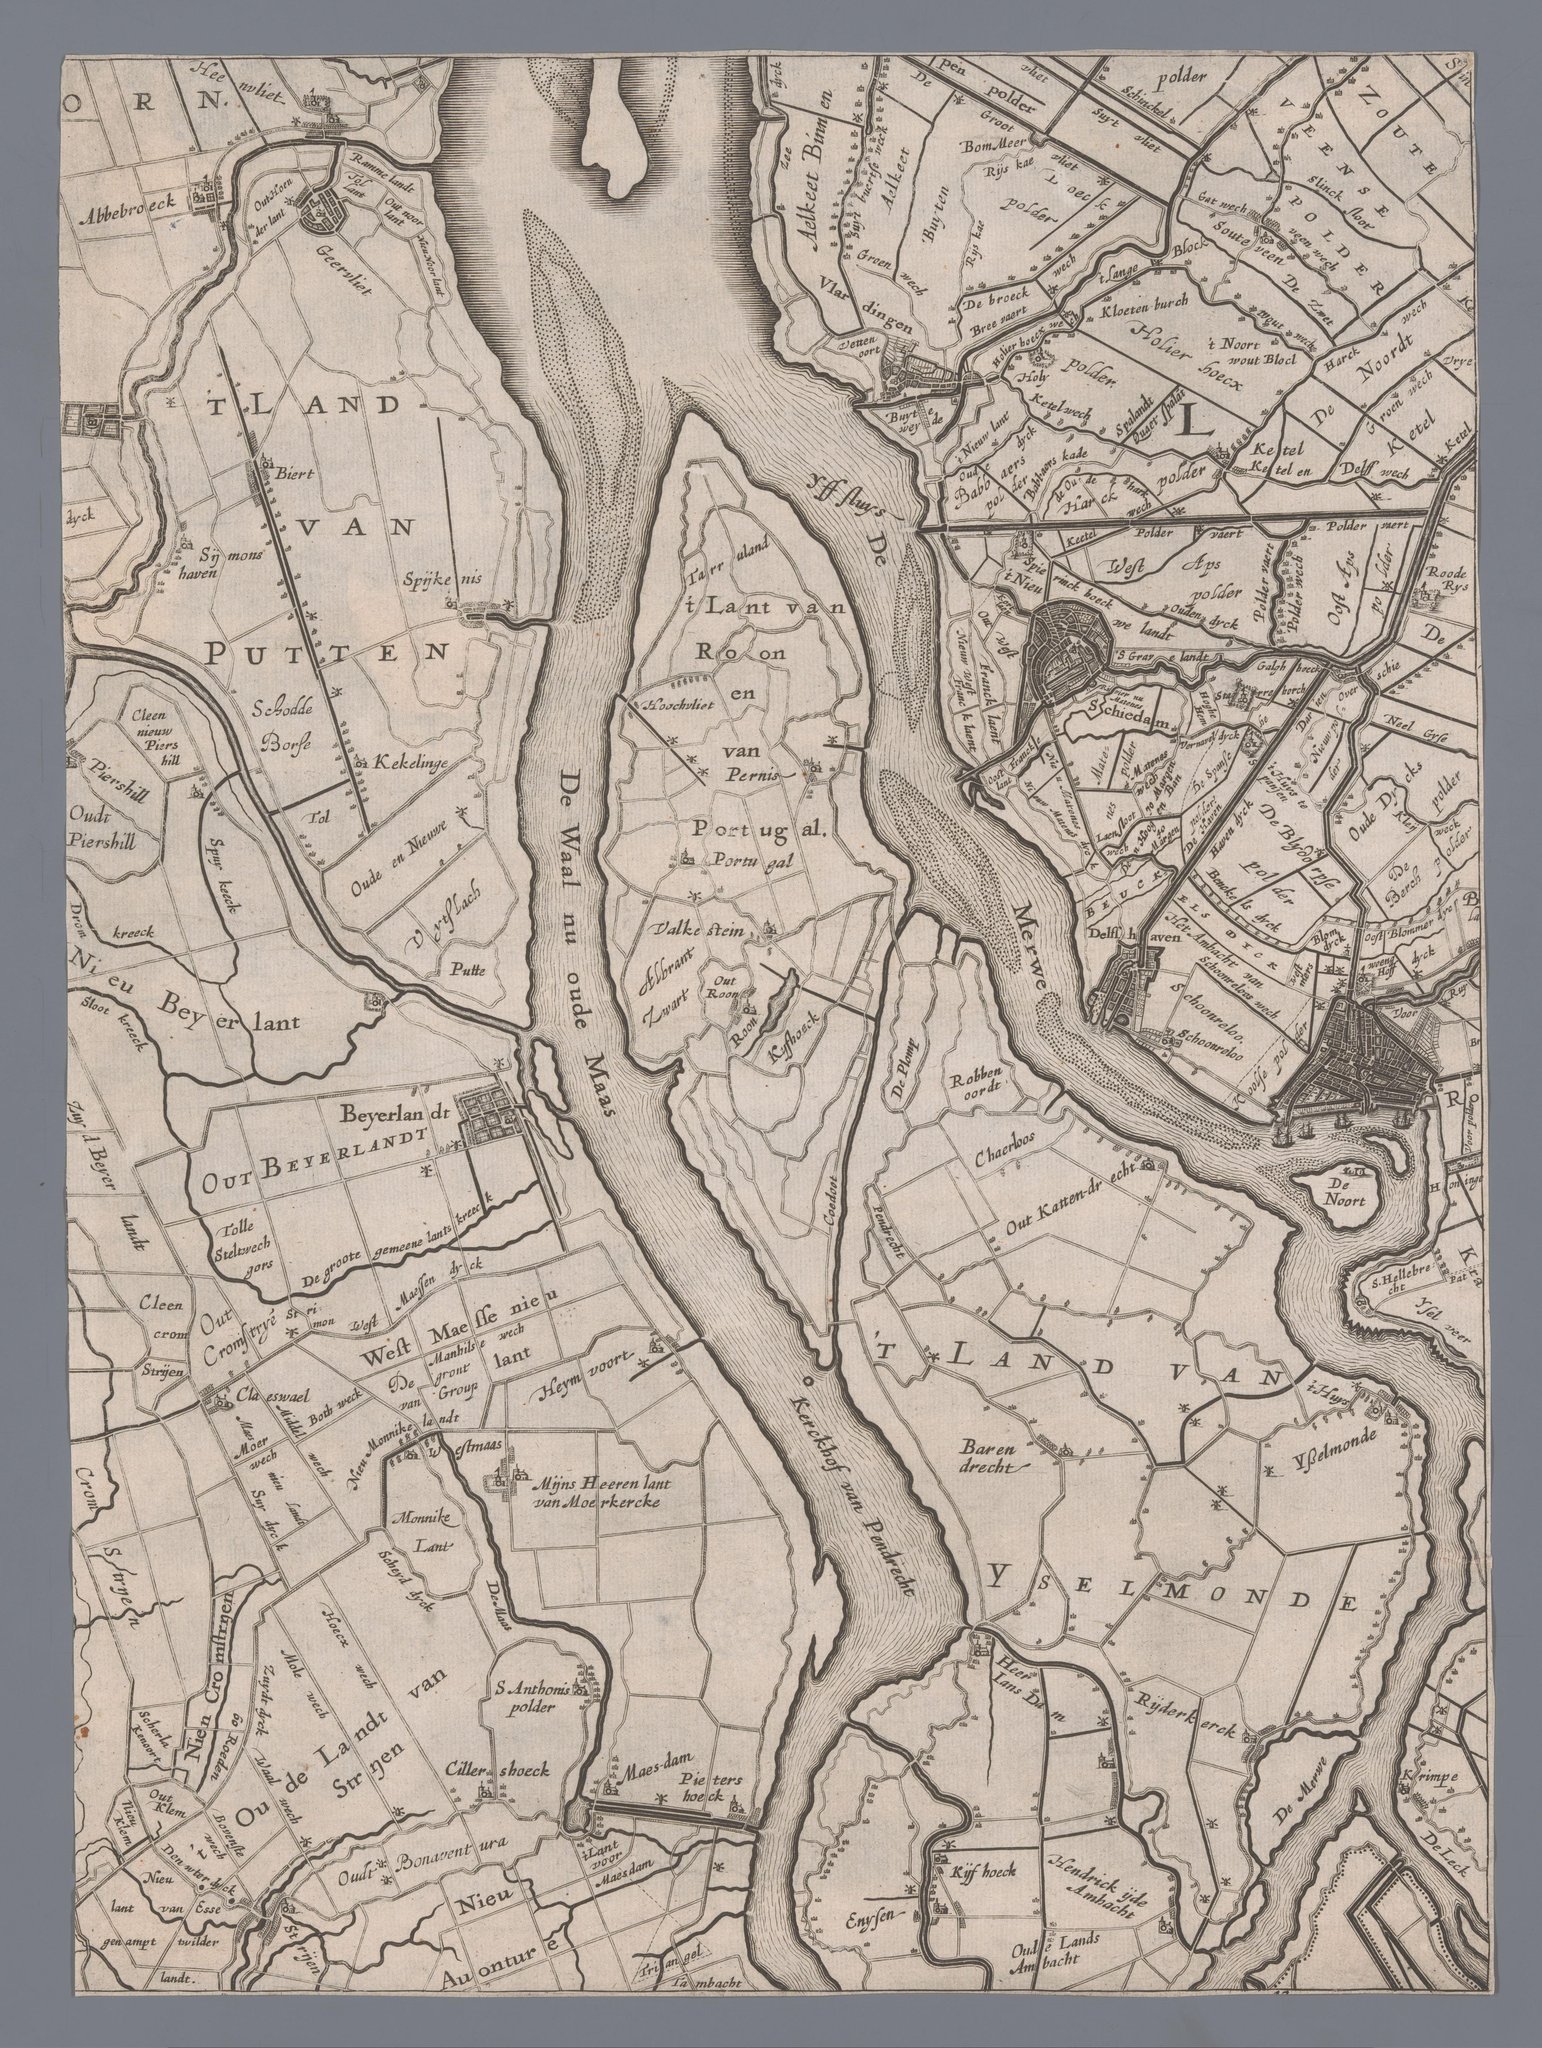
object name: print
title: Kaart van het Graafschap Holland en Utrecht (plaat 12)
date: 1639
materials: paper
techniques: engraving, etching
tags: maps, atlases, delfshaven, rotterdam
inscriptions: collector's mark: Lugt 2228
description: Onderdeel van een kaart samengesteld uit 40 bladen. Waarschijnlijk gaat het om de grootste kaart van Holland uit de zeventiende-eeuw. De kaart is uitgegeven in verschillende edities, deze kaart uit 1639 is de eerste editie.